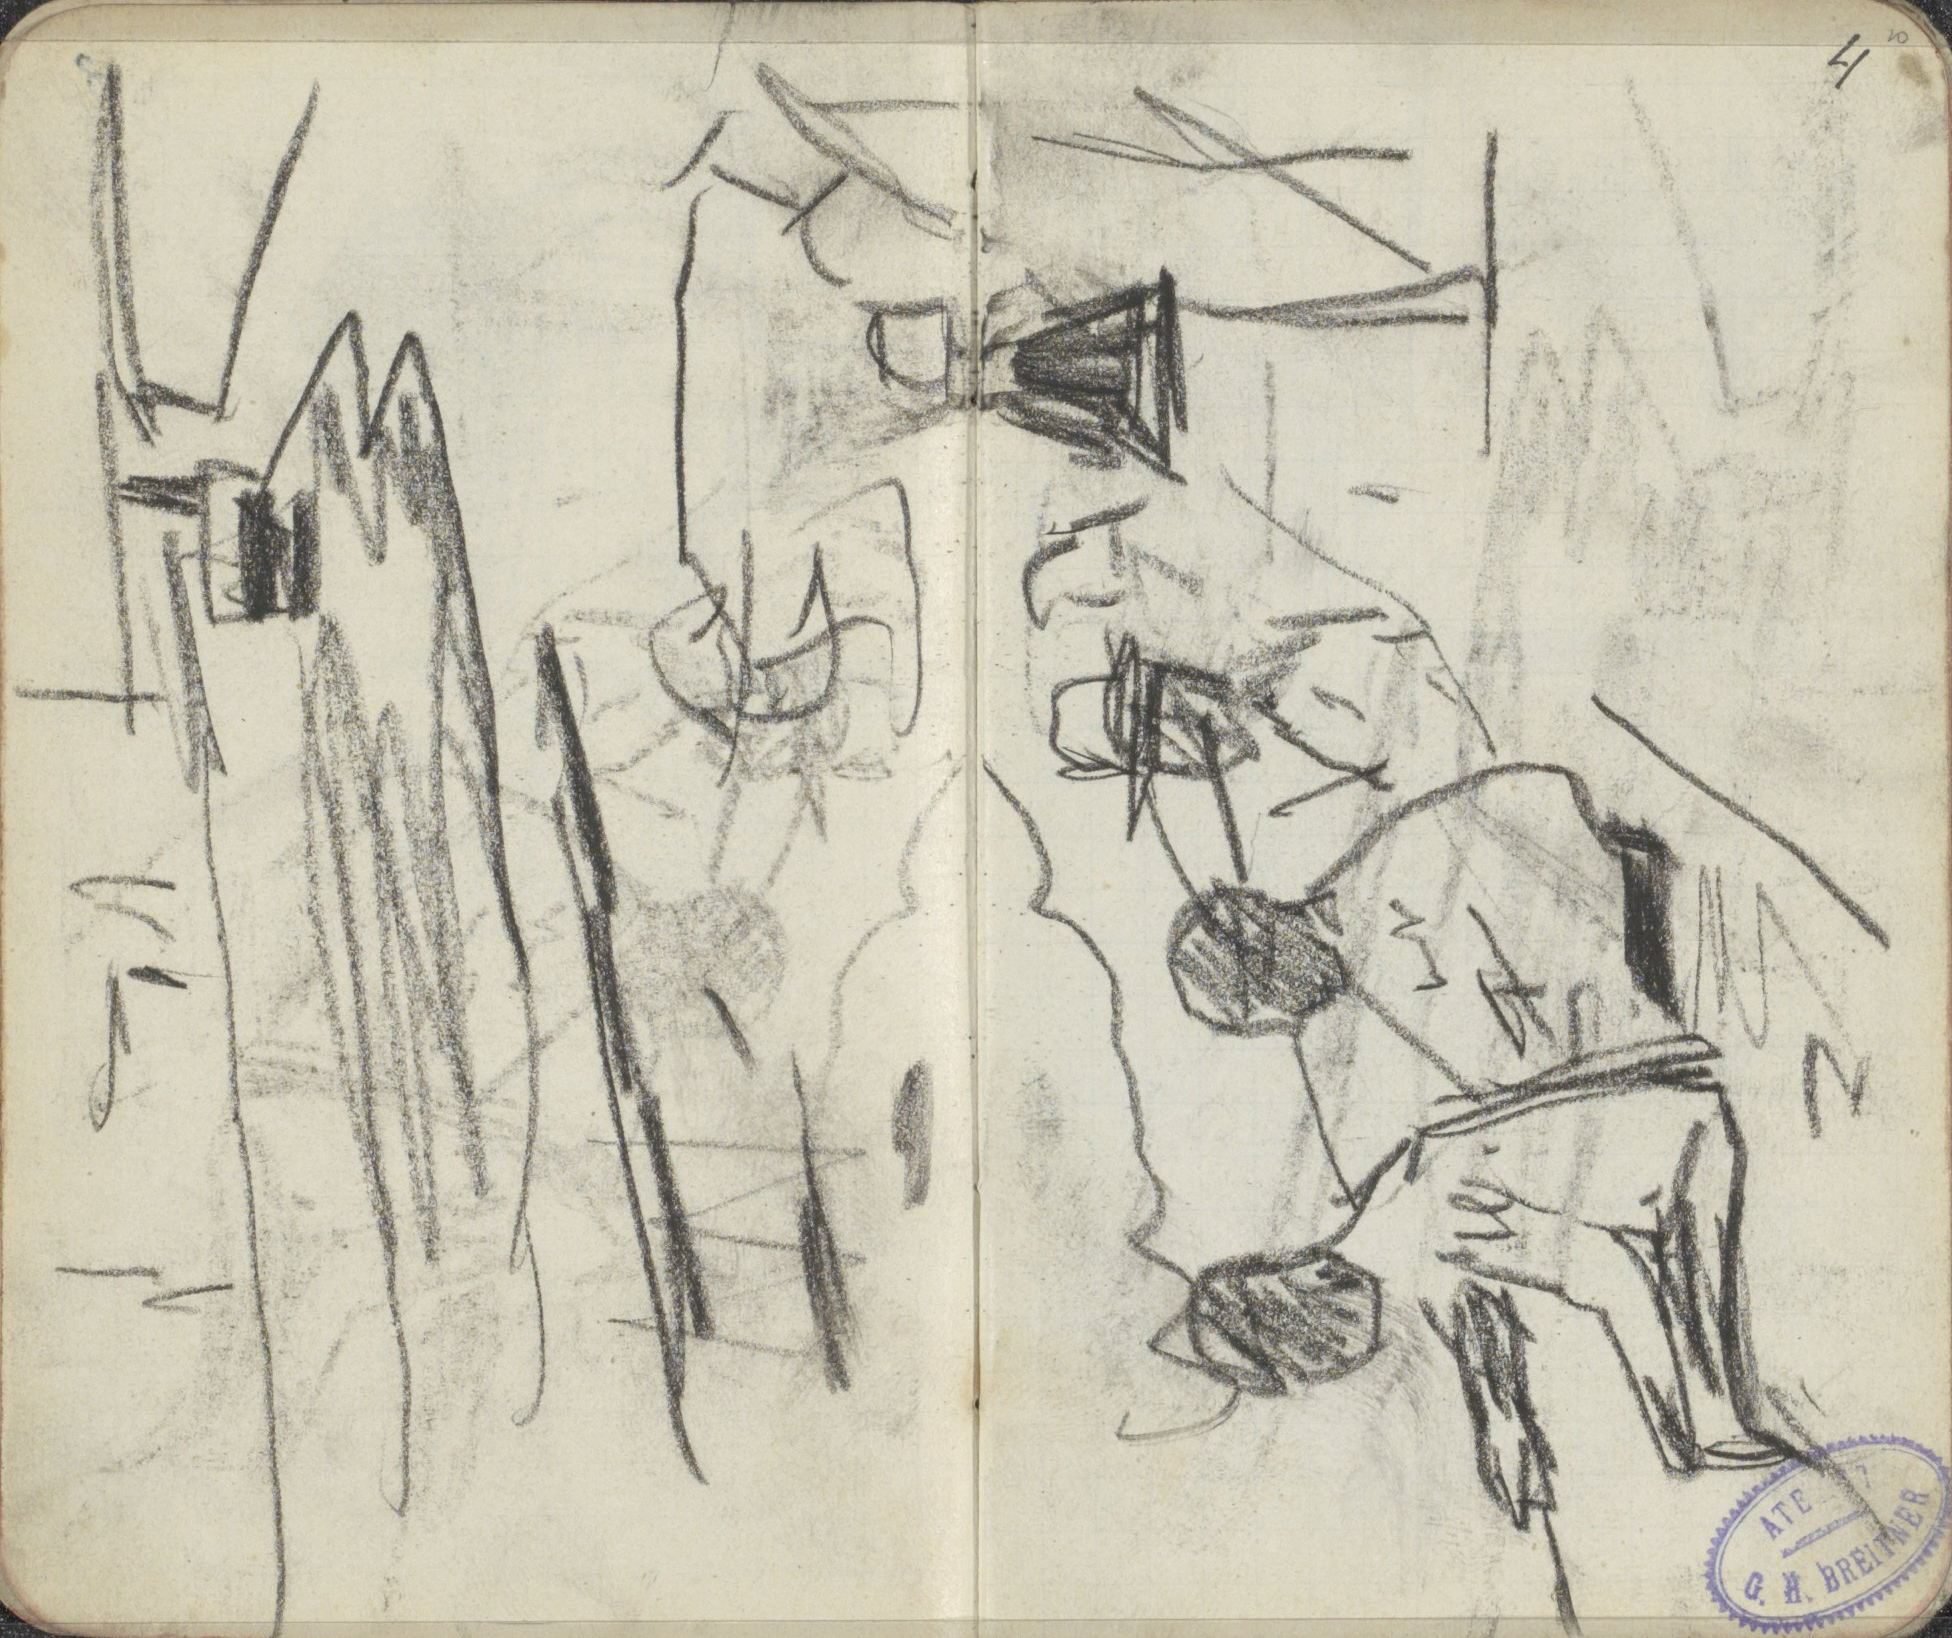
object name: sketchbook leaf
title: Zittende mannen, mogelijk op een kade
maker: george hendrik breitner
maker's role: draughtsman, painter, print maker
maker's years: 1857-1923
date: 1896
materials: chalk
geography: amsterdam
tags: canals, waters (in city), civic architecture; edifices; dwellings, amsterdam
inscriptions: workshop stamp: Lugt 291d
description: Pagina 9 en pagina 10 uit een schetsboek met 20 bladen.